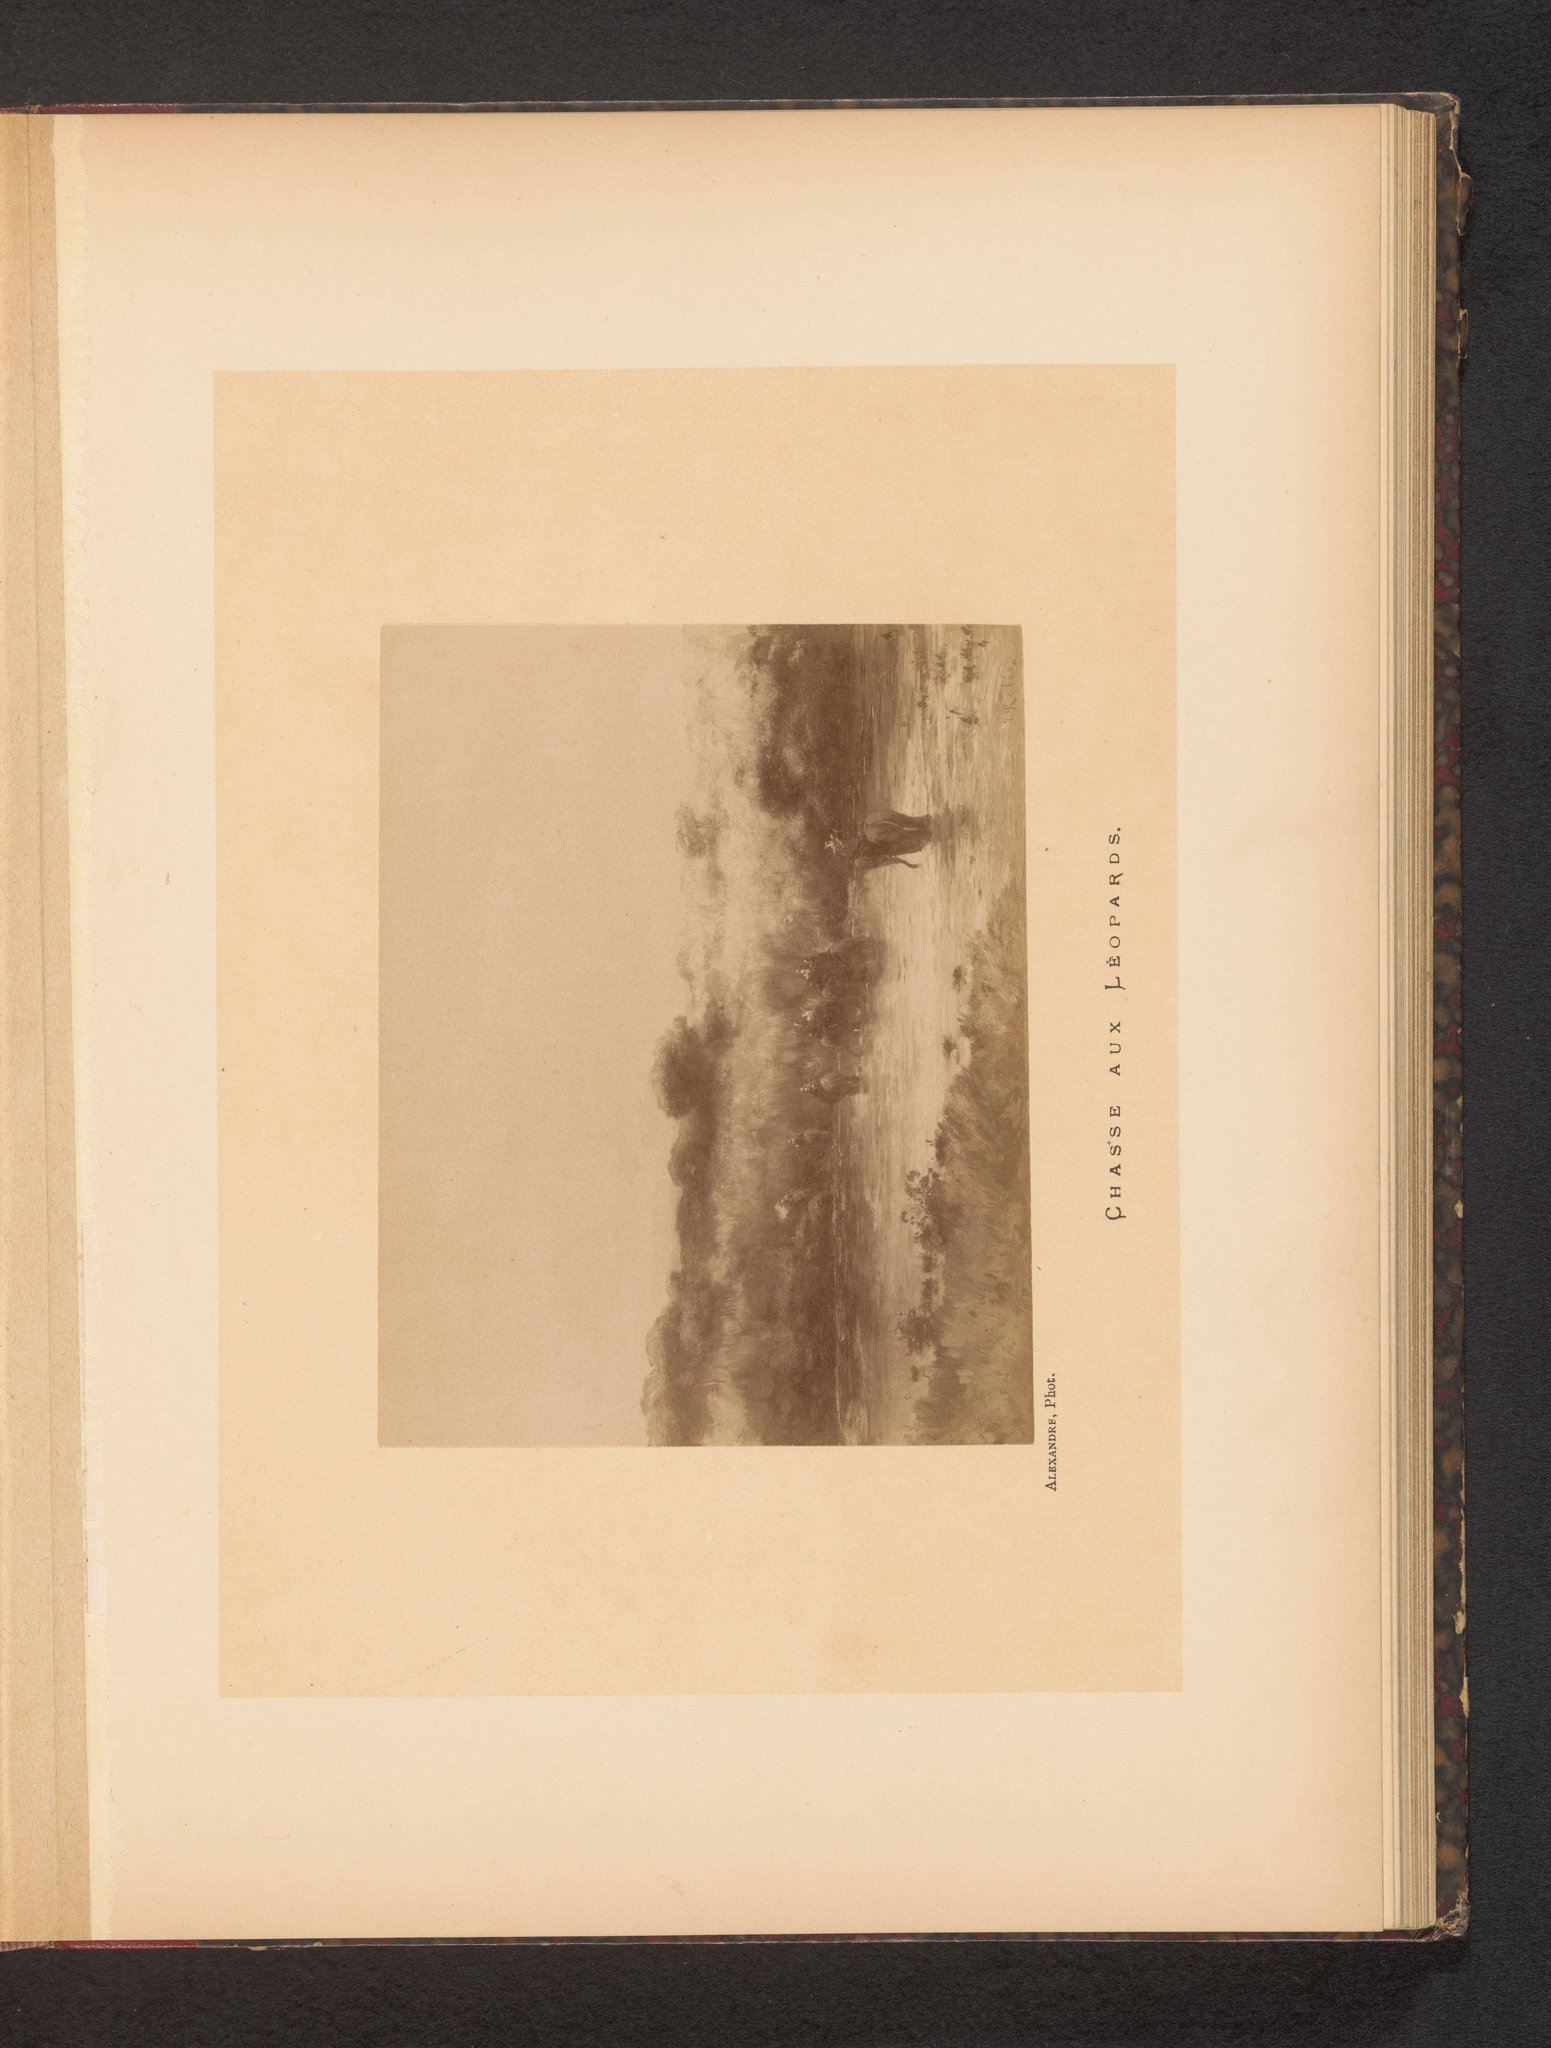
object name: reproduction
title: Chasse aux Leopards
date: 1878-1883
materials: photographic support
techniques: albumen print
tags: hunt ~ predatory animals (fox, lion)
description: Foto op tweede ongenummerde pagina na pagina 51.